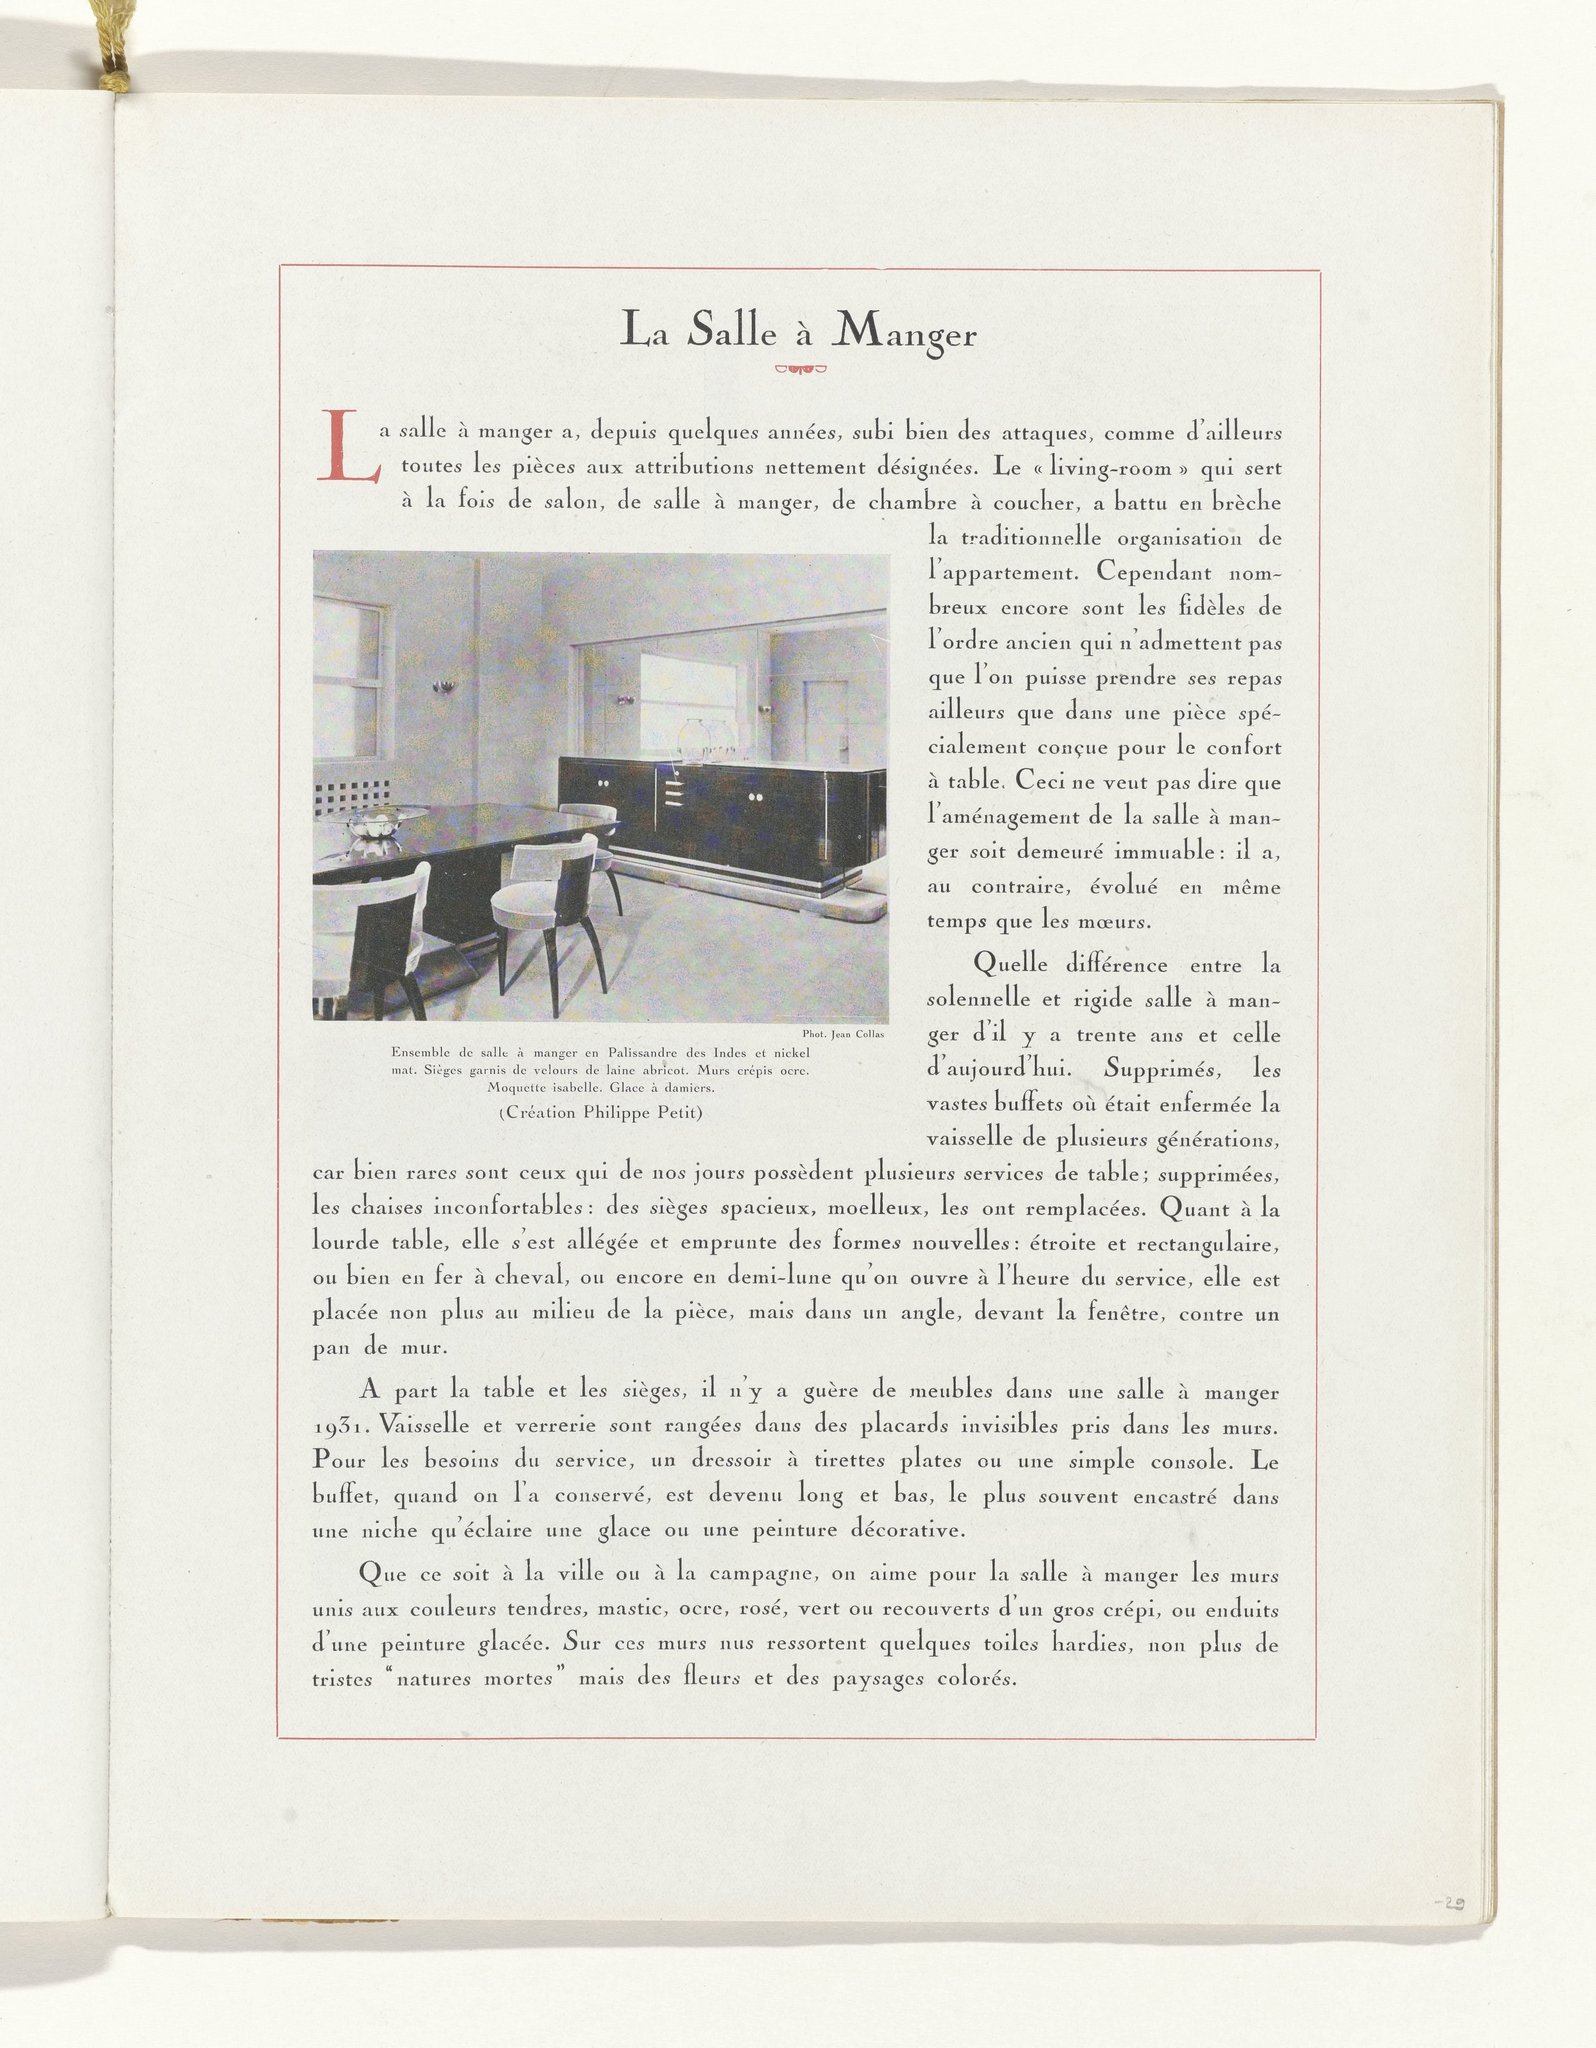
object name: magazine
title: Art - Goût - Beauté, Feuillets de l' élégance féminine, Novembre 1931, No. 135, 12e Année, p. 29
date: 1931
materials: paper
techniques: printing, photography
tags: fashion plates, dining-room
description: Tekst over inrichting eetkamer met een afbeelding van een eetkamer van Philippe Petit. Pagina uit het modetijdschrift Art-Goût-Beauté (1920-1933).